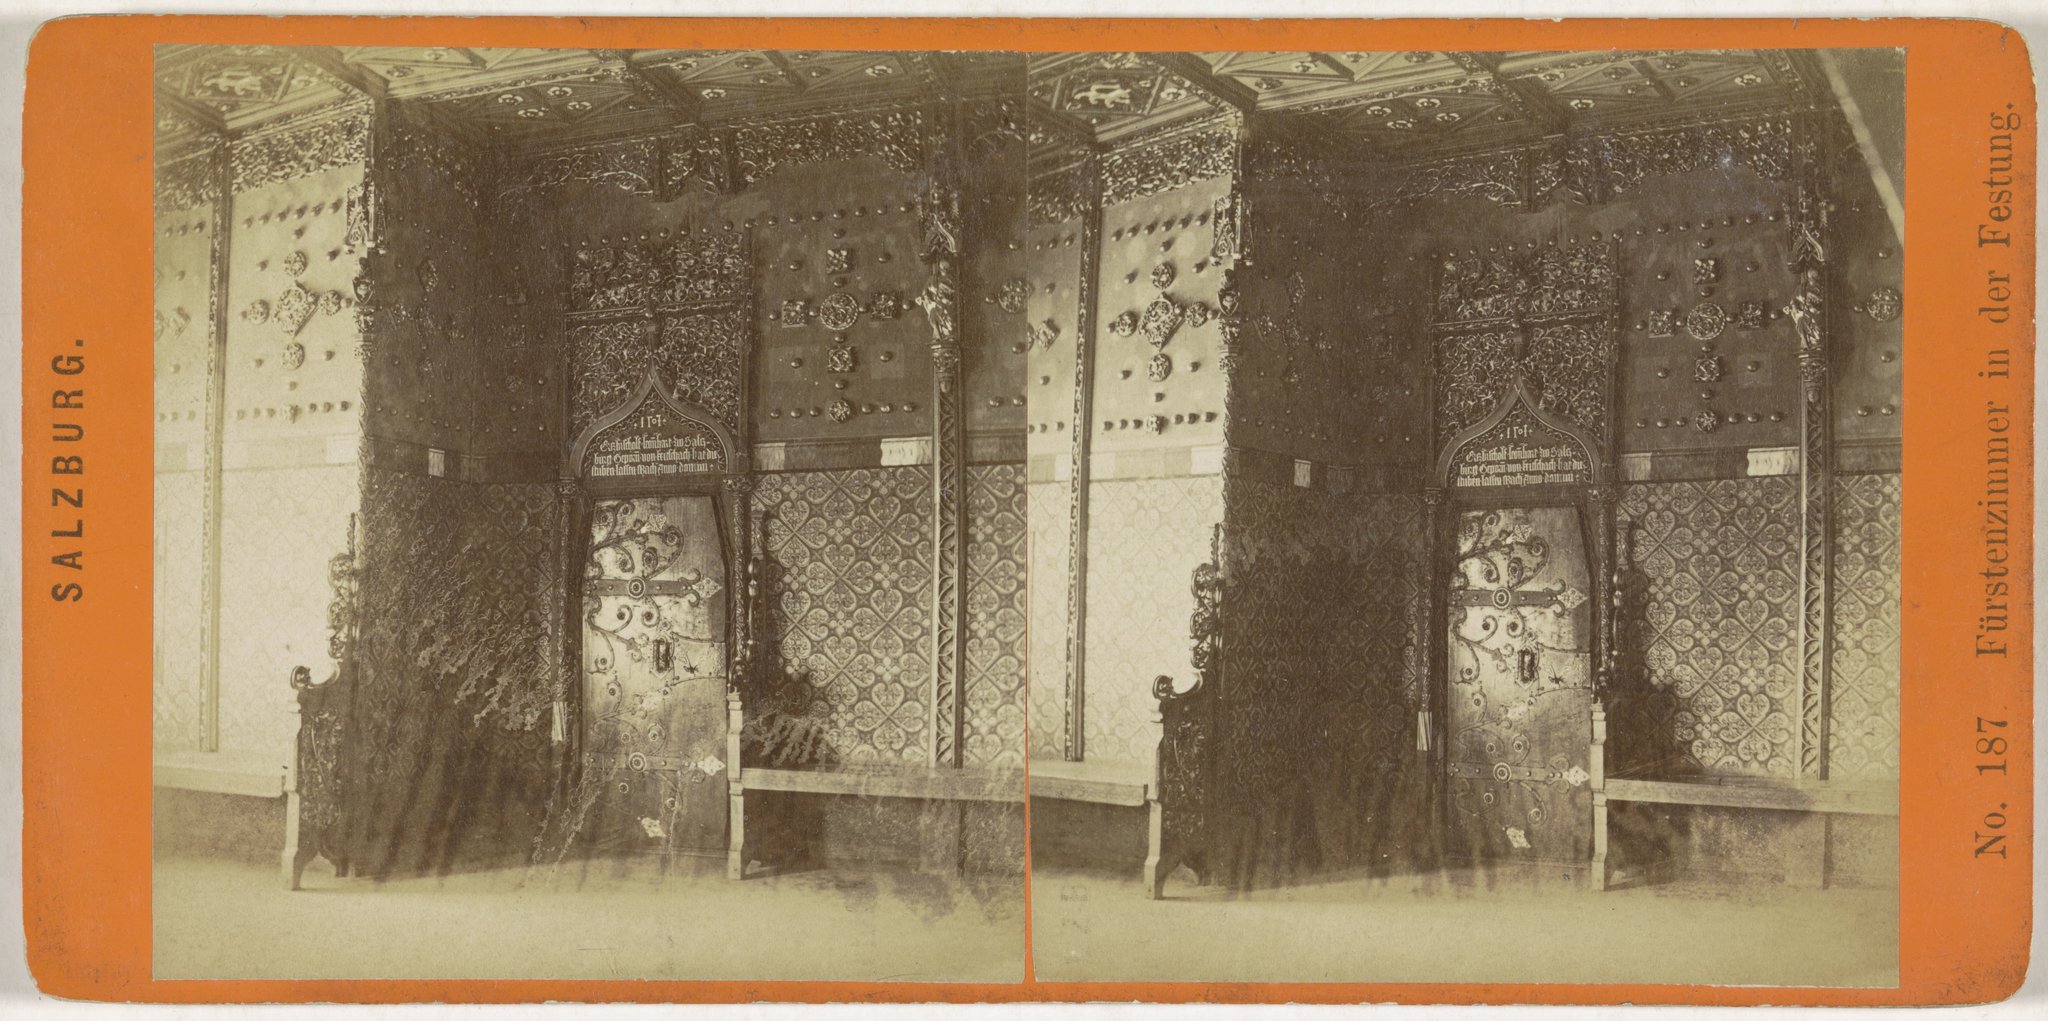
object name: stereograph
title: Vorstenkamer ofwel gouden kamer, in de vesting Hohensalzburg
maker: Anonymous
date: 1862-1880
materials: cardboard, paper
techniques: albumen print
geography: salzburg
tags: palace - aa - civic architecture: inside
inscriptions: number: ‘No. 187’, : ‘Prämiirt mit silbernen Medaillen bei den Ausstellungen/ in Paris, Hamburg & Salzburg’